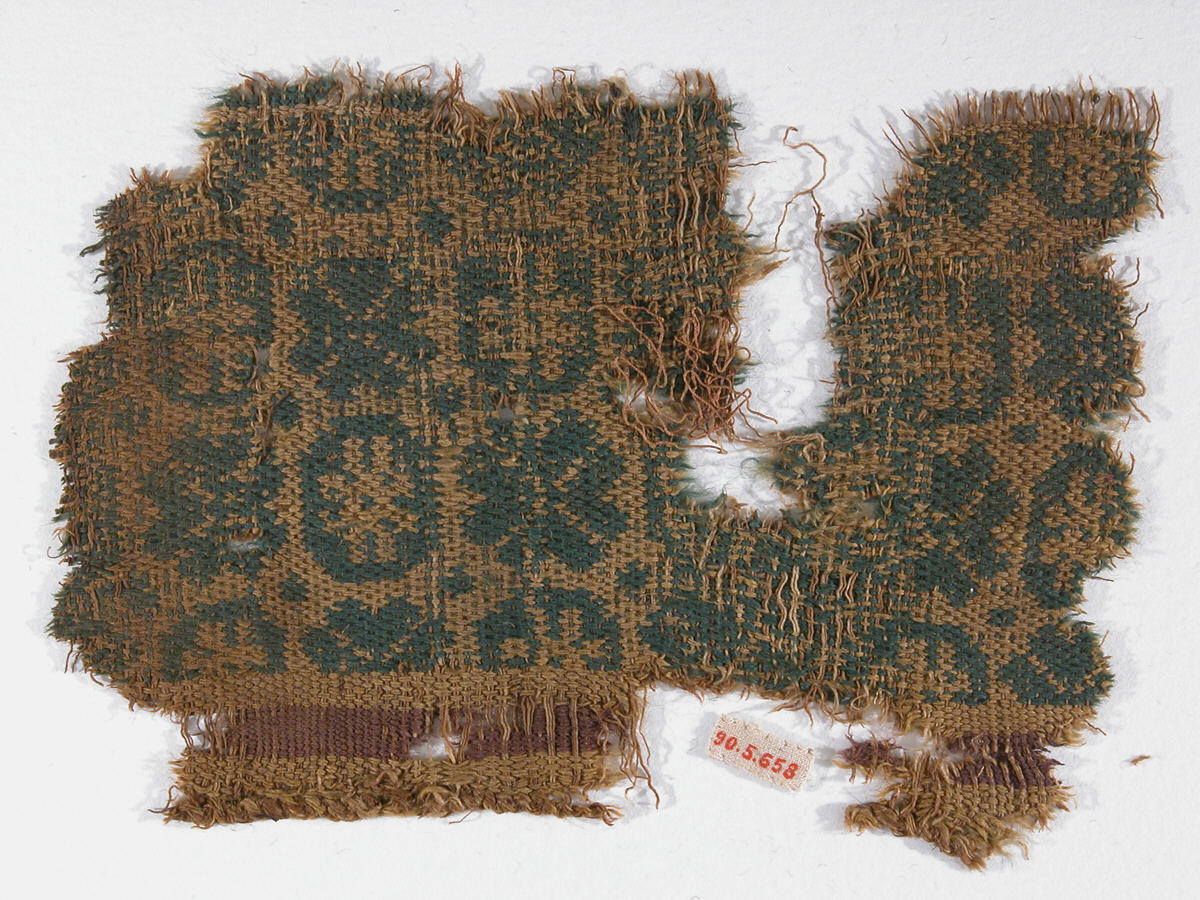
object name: textile fragment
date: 401-500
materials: wool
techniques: weave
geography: egypt